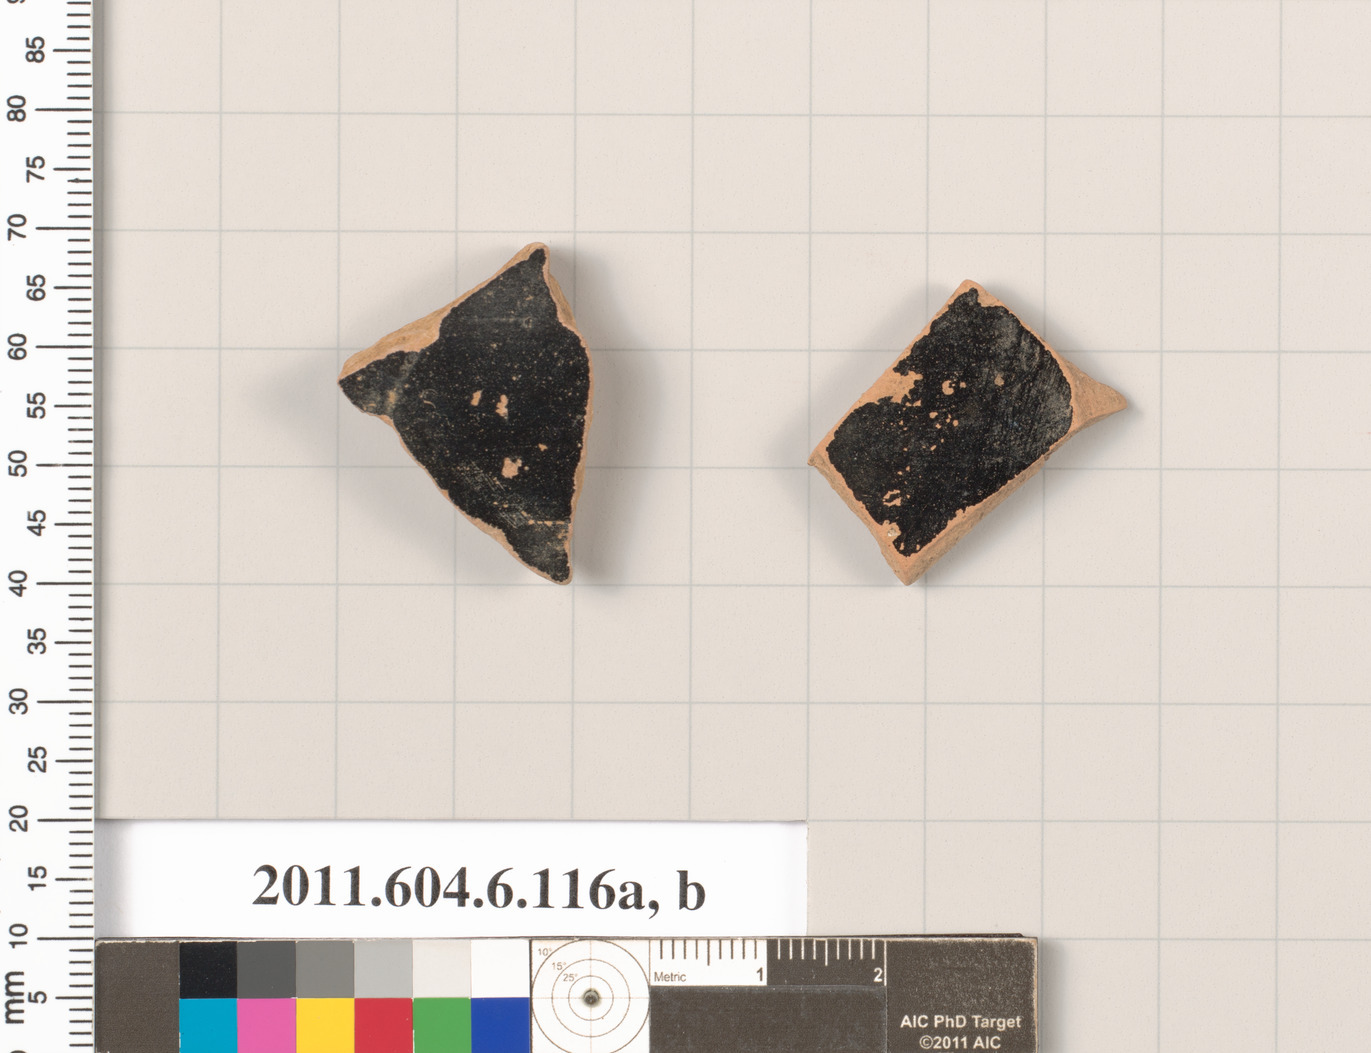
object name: undetermined open shape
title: Terracotta fragments of open shapes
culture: greek, attic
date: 600-401 BCE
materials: terracotta